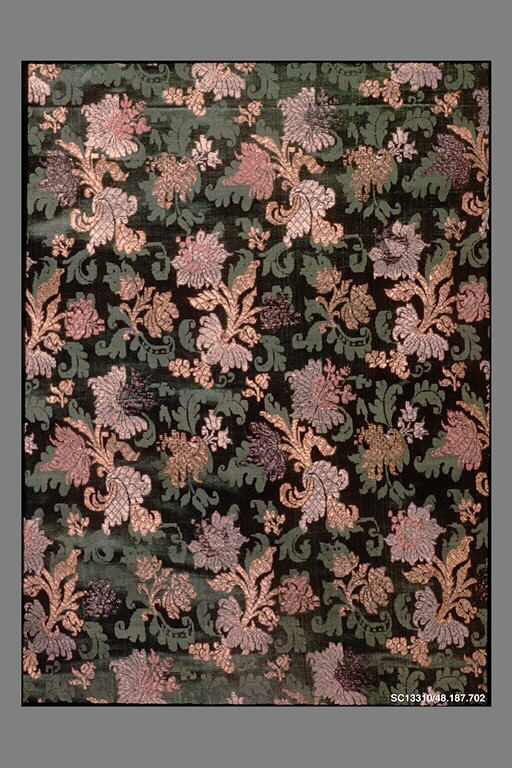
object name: piece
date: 1690-1700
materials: metal thread, silk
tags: flowers,leaves